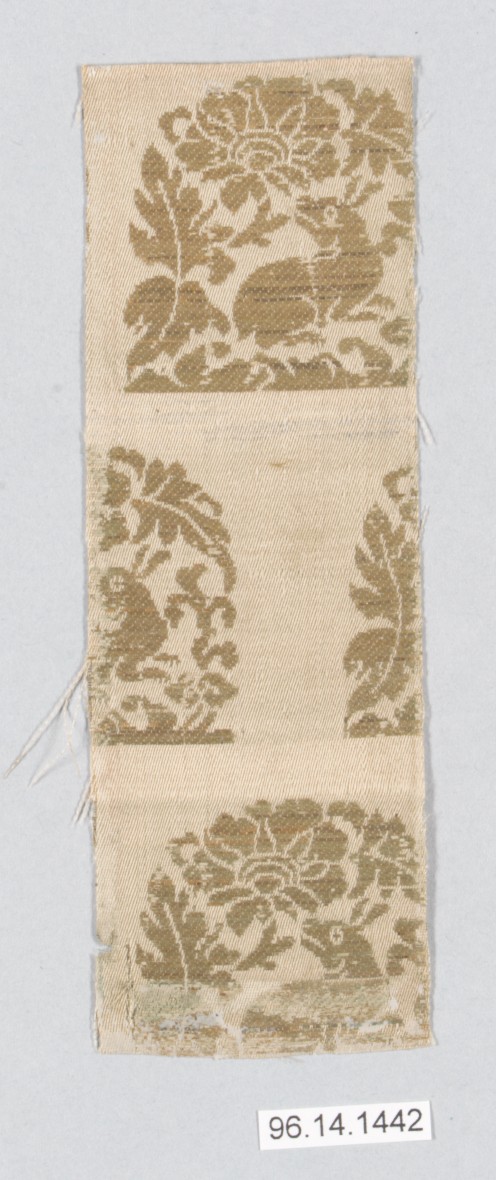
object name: piece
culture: japanese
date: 1767-1800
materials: silk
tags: flowers,leaves